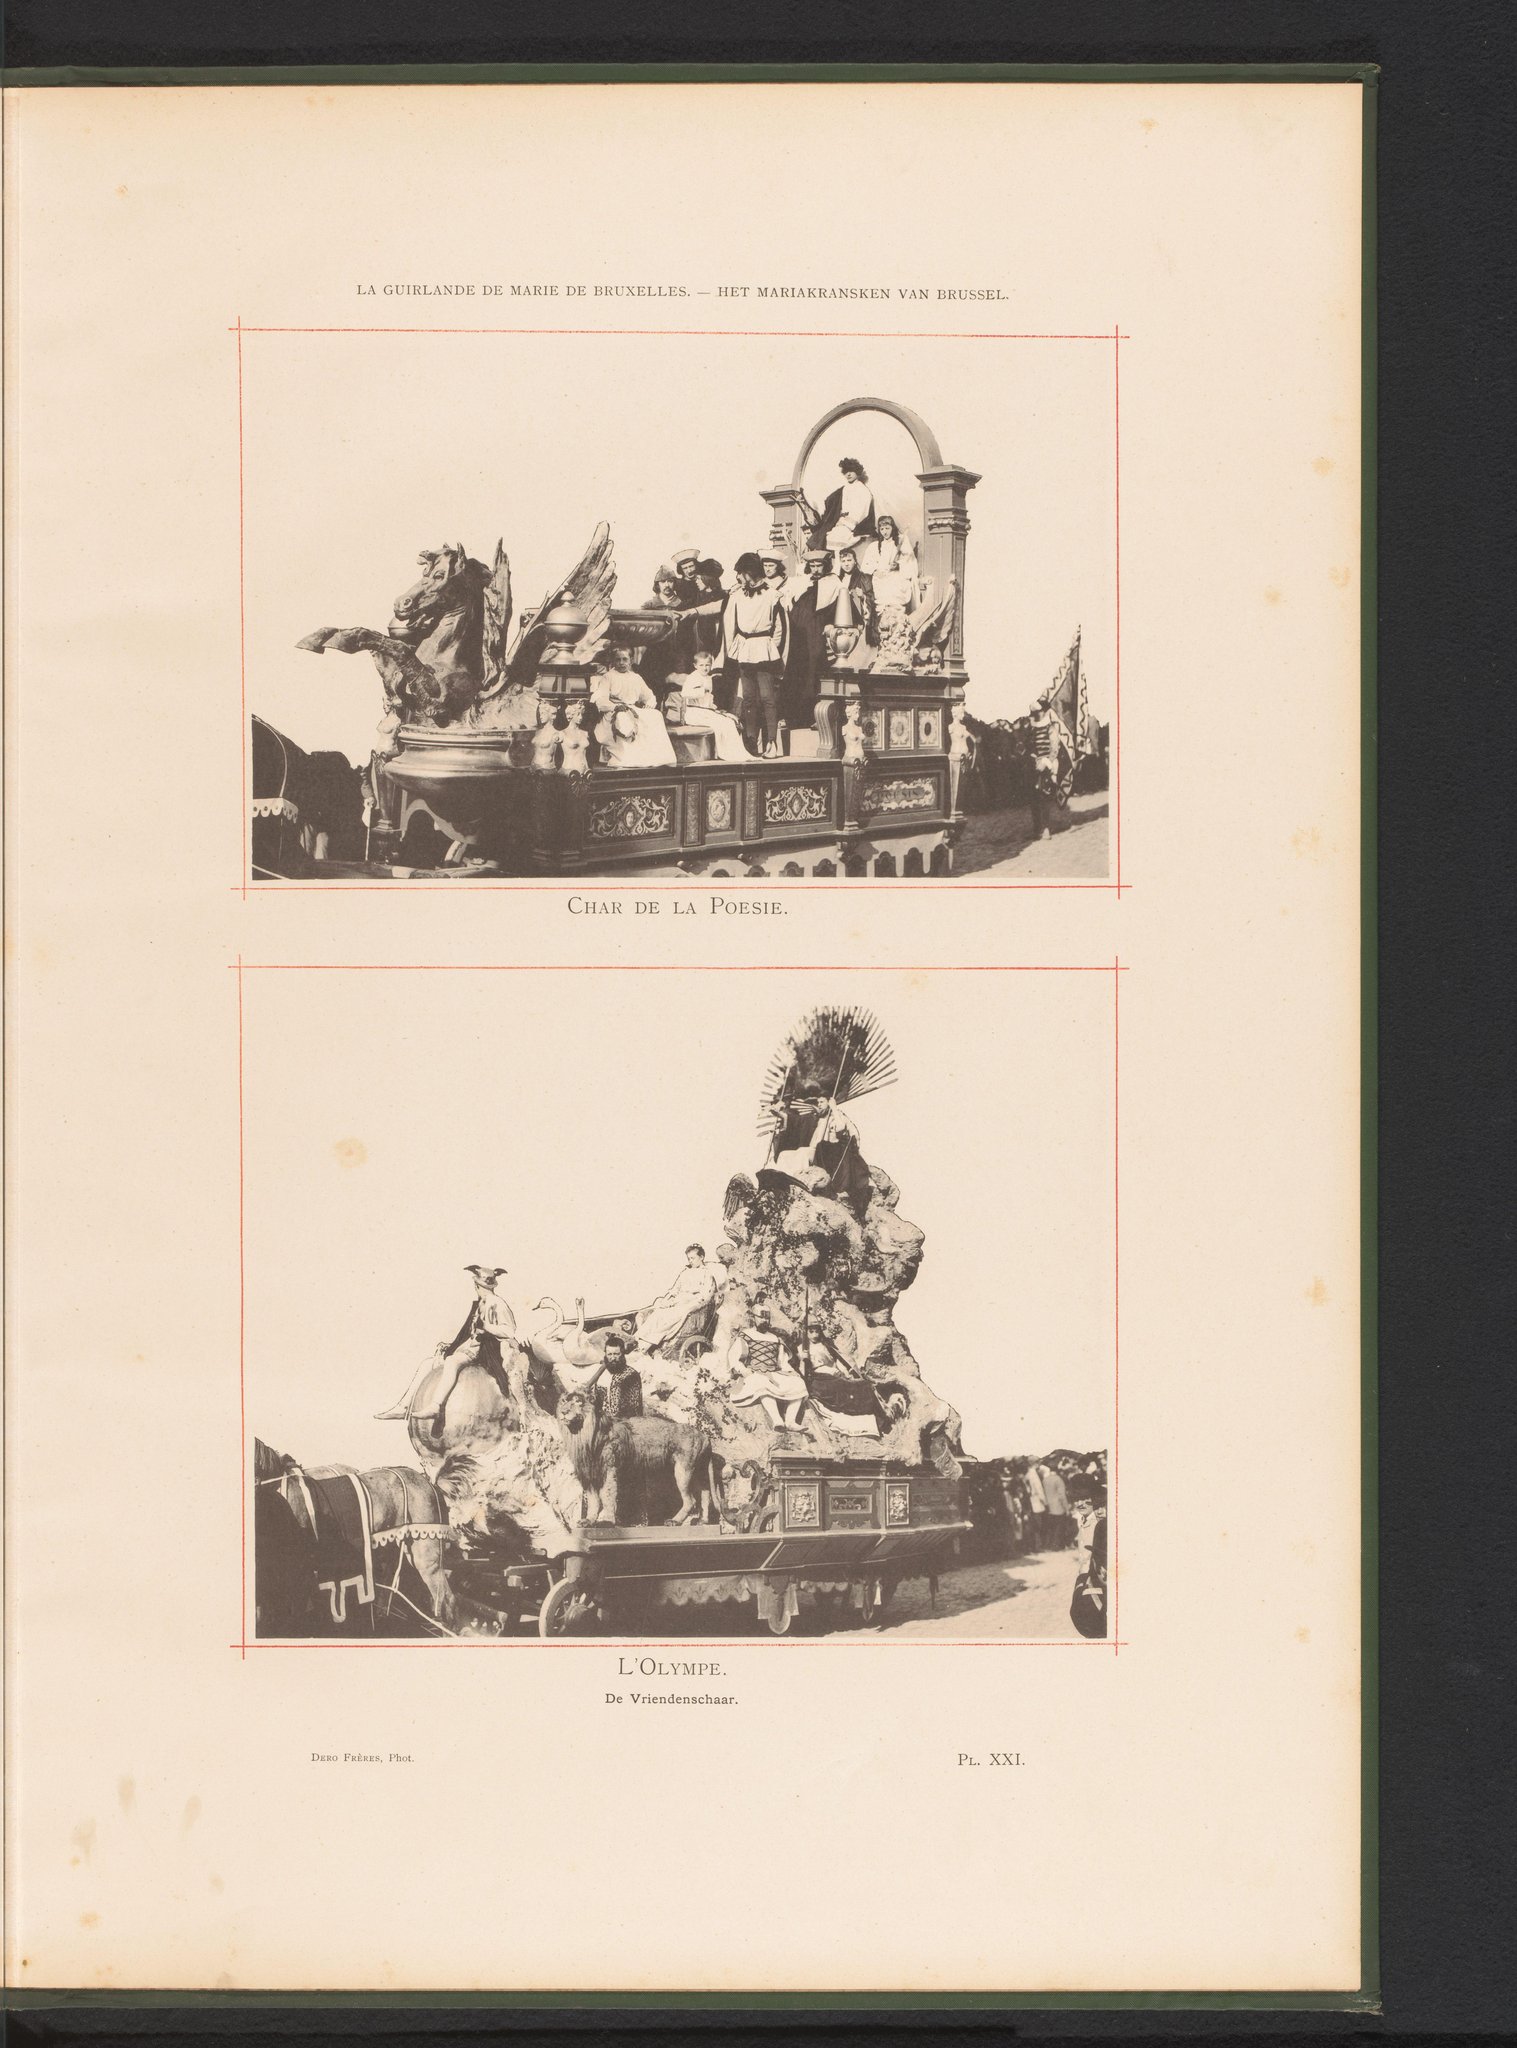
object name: photomechanical print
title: L'Olympe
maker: joseph maes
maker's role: fotograaf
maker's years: 1838-1908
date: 1892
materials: paper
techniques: photograph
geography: antwerp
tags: public festivities (+ parade, pageant, cavalcade ~ festive activities), antwerp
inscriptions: inscription: ‘LA GUIRLANDE DE MARIE DE BRUXELLES. - HET MARIAKRANSKEN VAN BRUSSEL.’, number: ‘Pl. XXI.’, inscription: ‘De Vriendenschaar.’